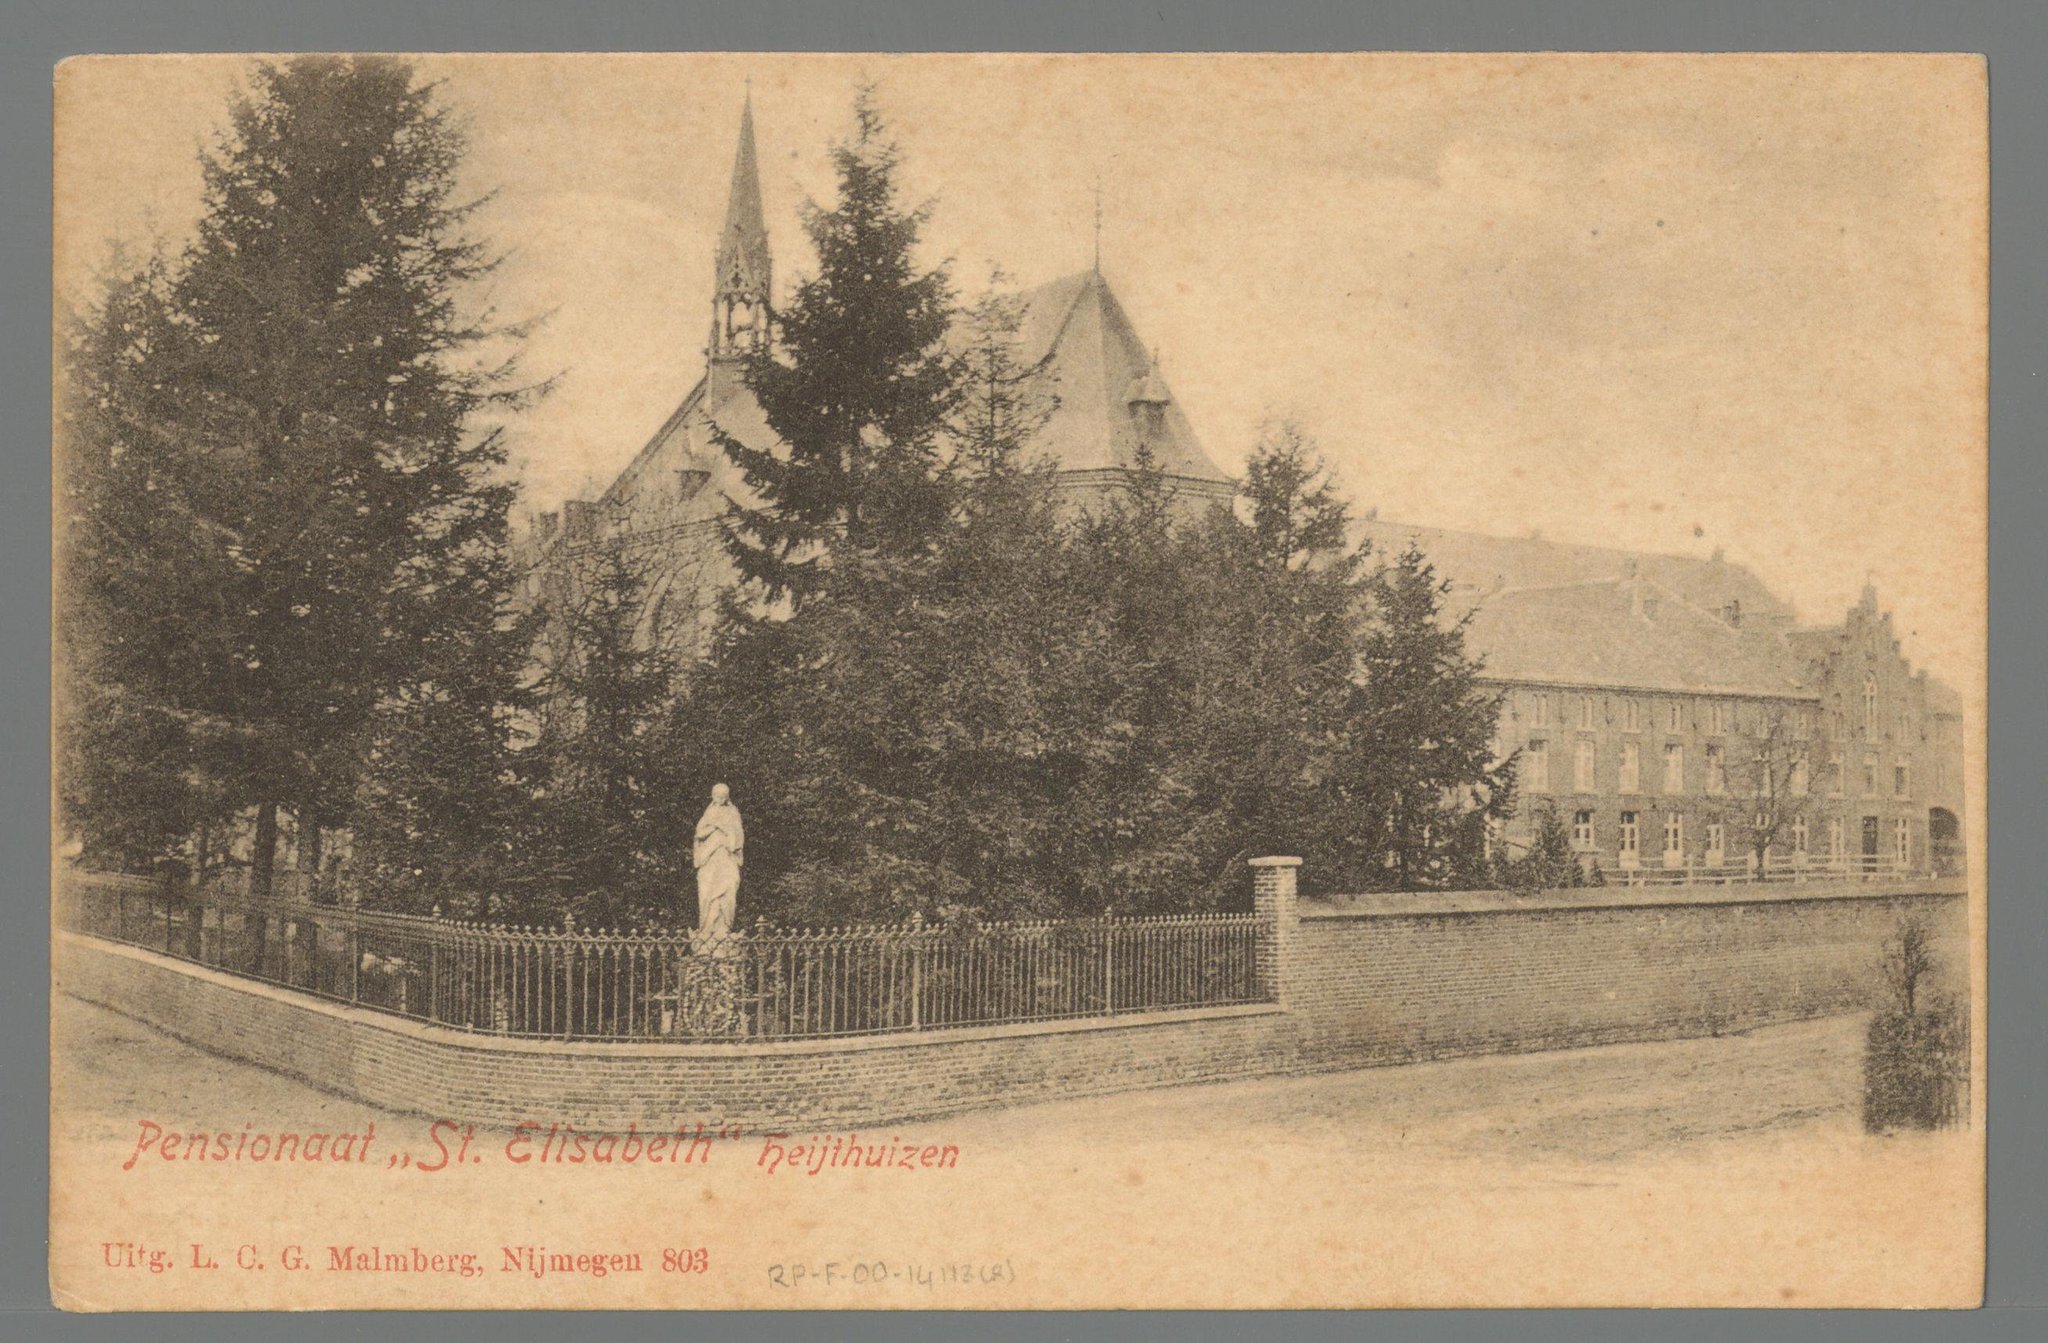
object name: photomechanical print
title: Pensionaat "St. Elisabeth". Heijthuizen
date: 1897-1901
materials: cardboard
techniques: photograph, writing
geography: nijmegen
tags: abbey, monastery, convent ~ roman catholic church, monument, statue